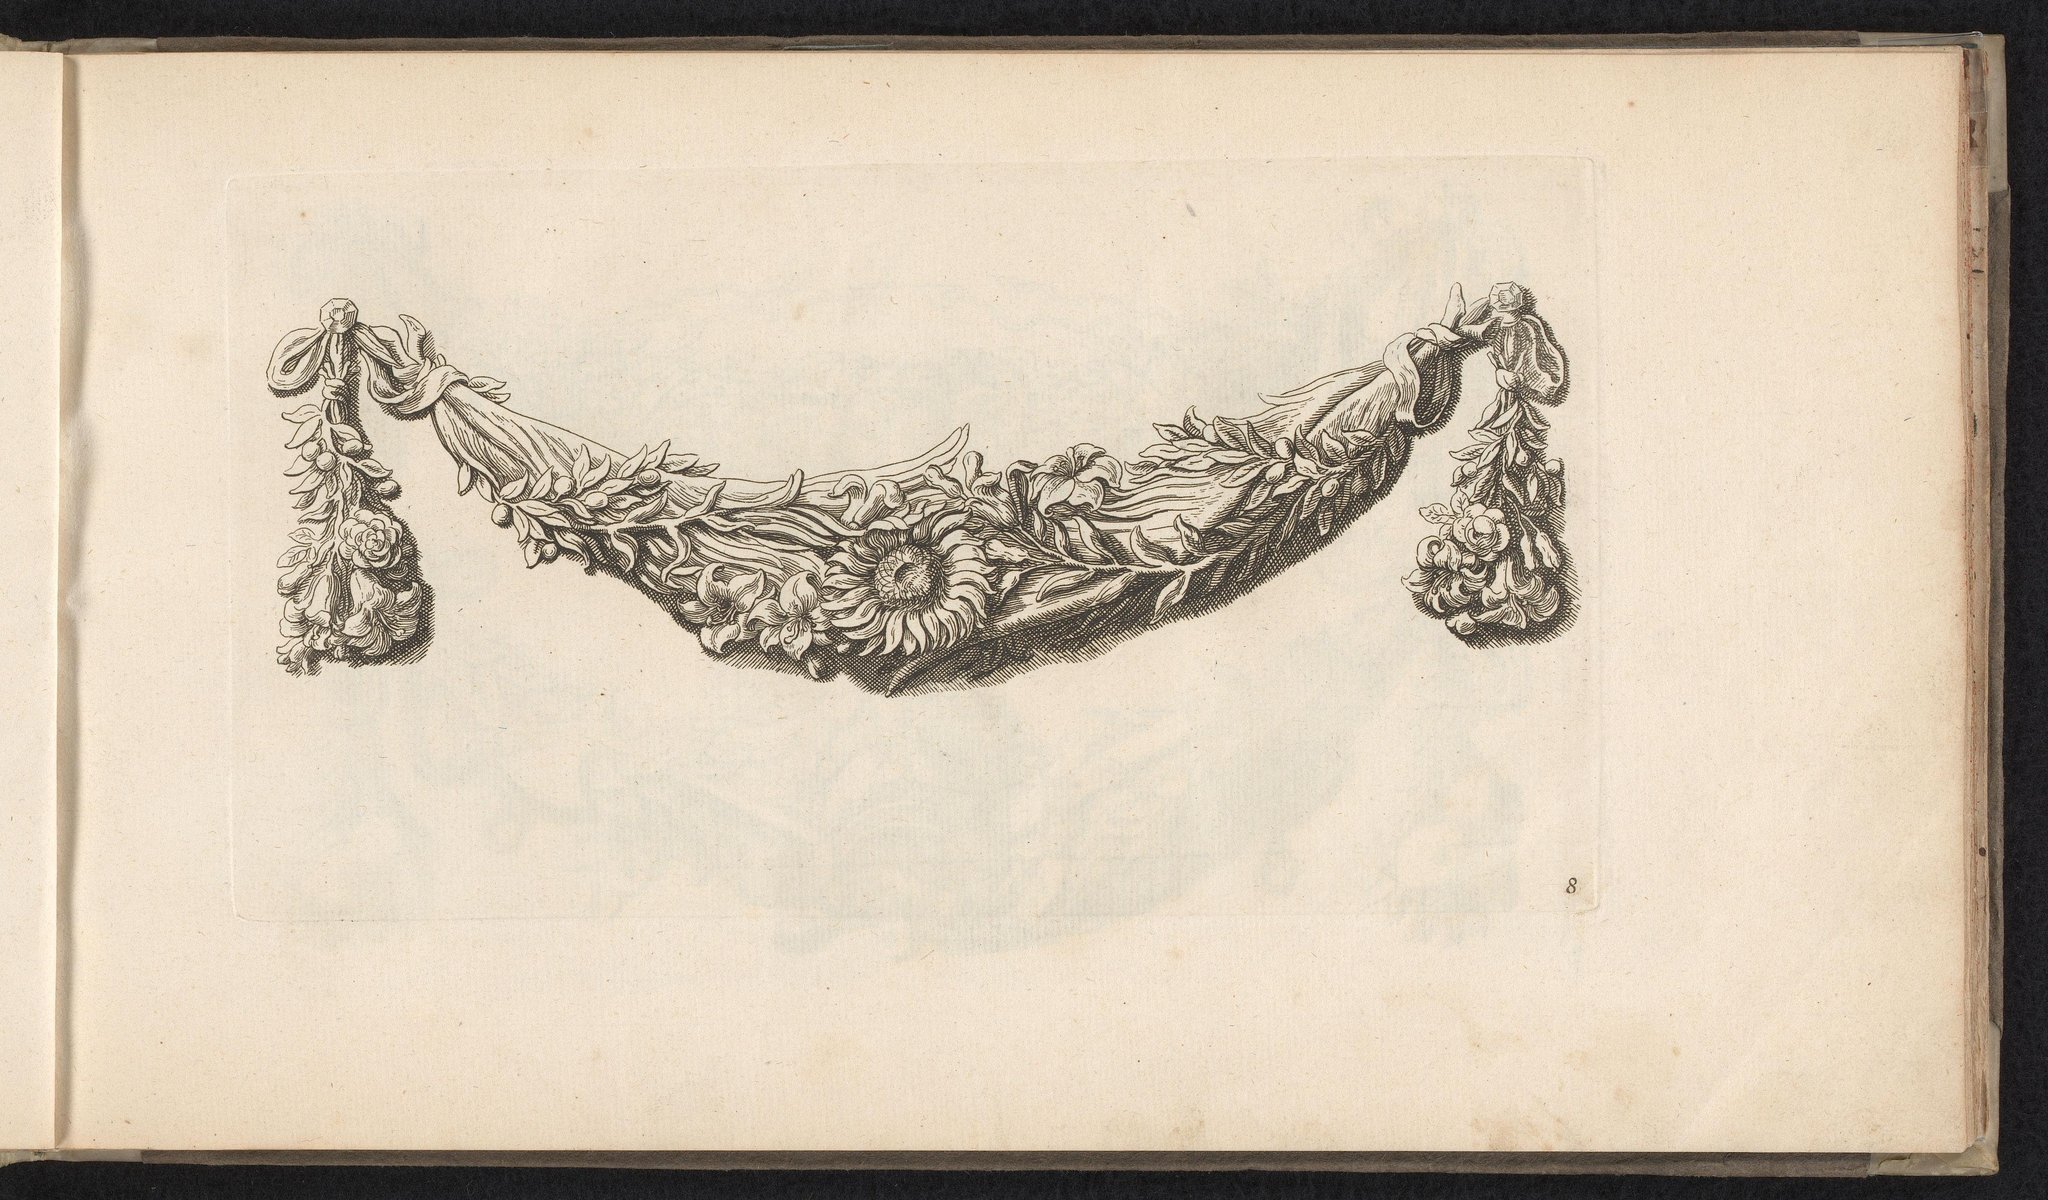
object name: ornament print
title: Festoen met lelies en een zonnebloem uit het stadhuis van Amsterdam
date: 1665-1685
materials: ink, paper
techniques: etching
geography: amsterdam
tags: flowers: sunflower, flowers: lily, ornament ~ festoon, garland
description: Prent uit elf genummerde prenten met festoenen. Kopieën in dezelfde richting naar de prenten in Artus Quellinus, Prima Pars Praecipuarium (…), Amsterdam 1665. Gebonden in 19de-eeuwse band met blauwe kaft en witte rug, genummerd: 3.